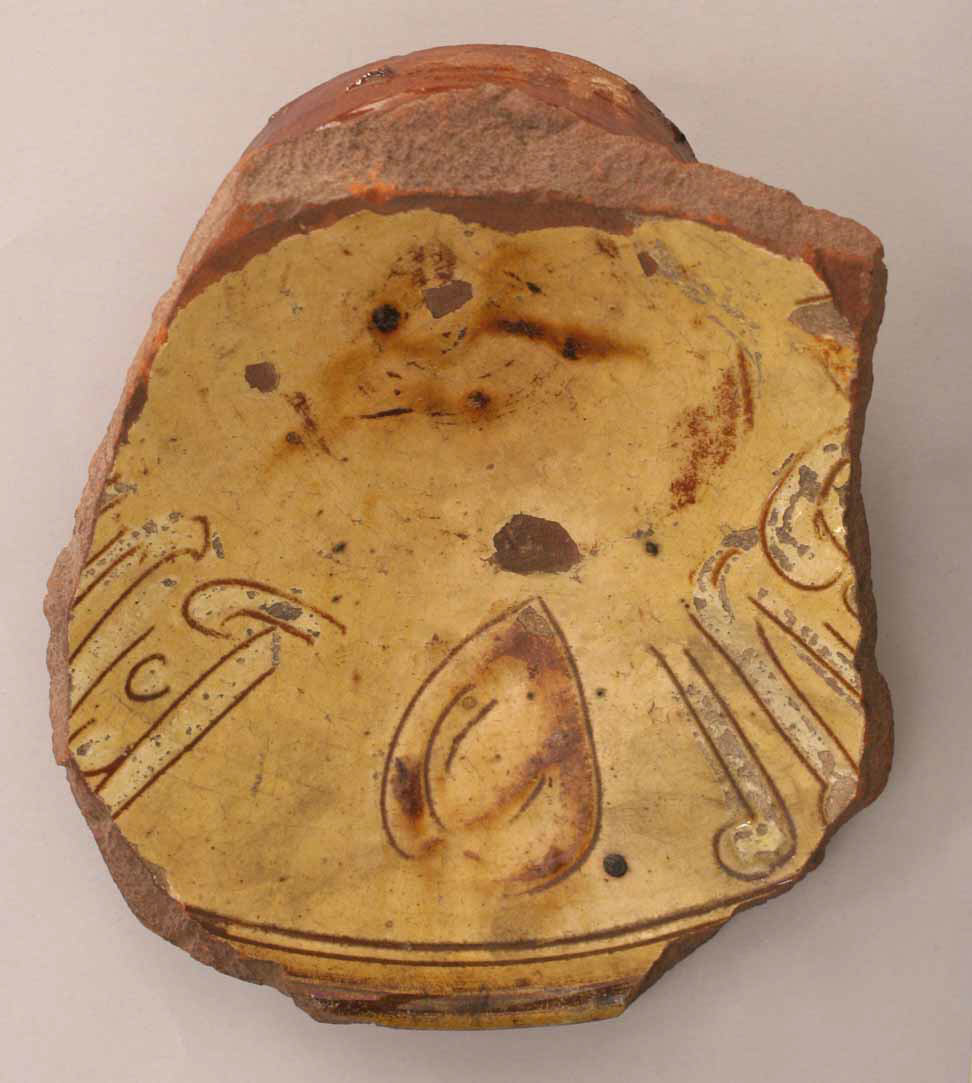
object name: fragment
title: Fragment of a Bowl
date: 1301-1500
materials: earthenware, glaze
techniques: coloring, incising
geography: egypt